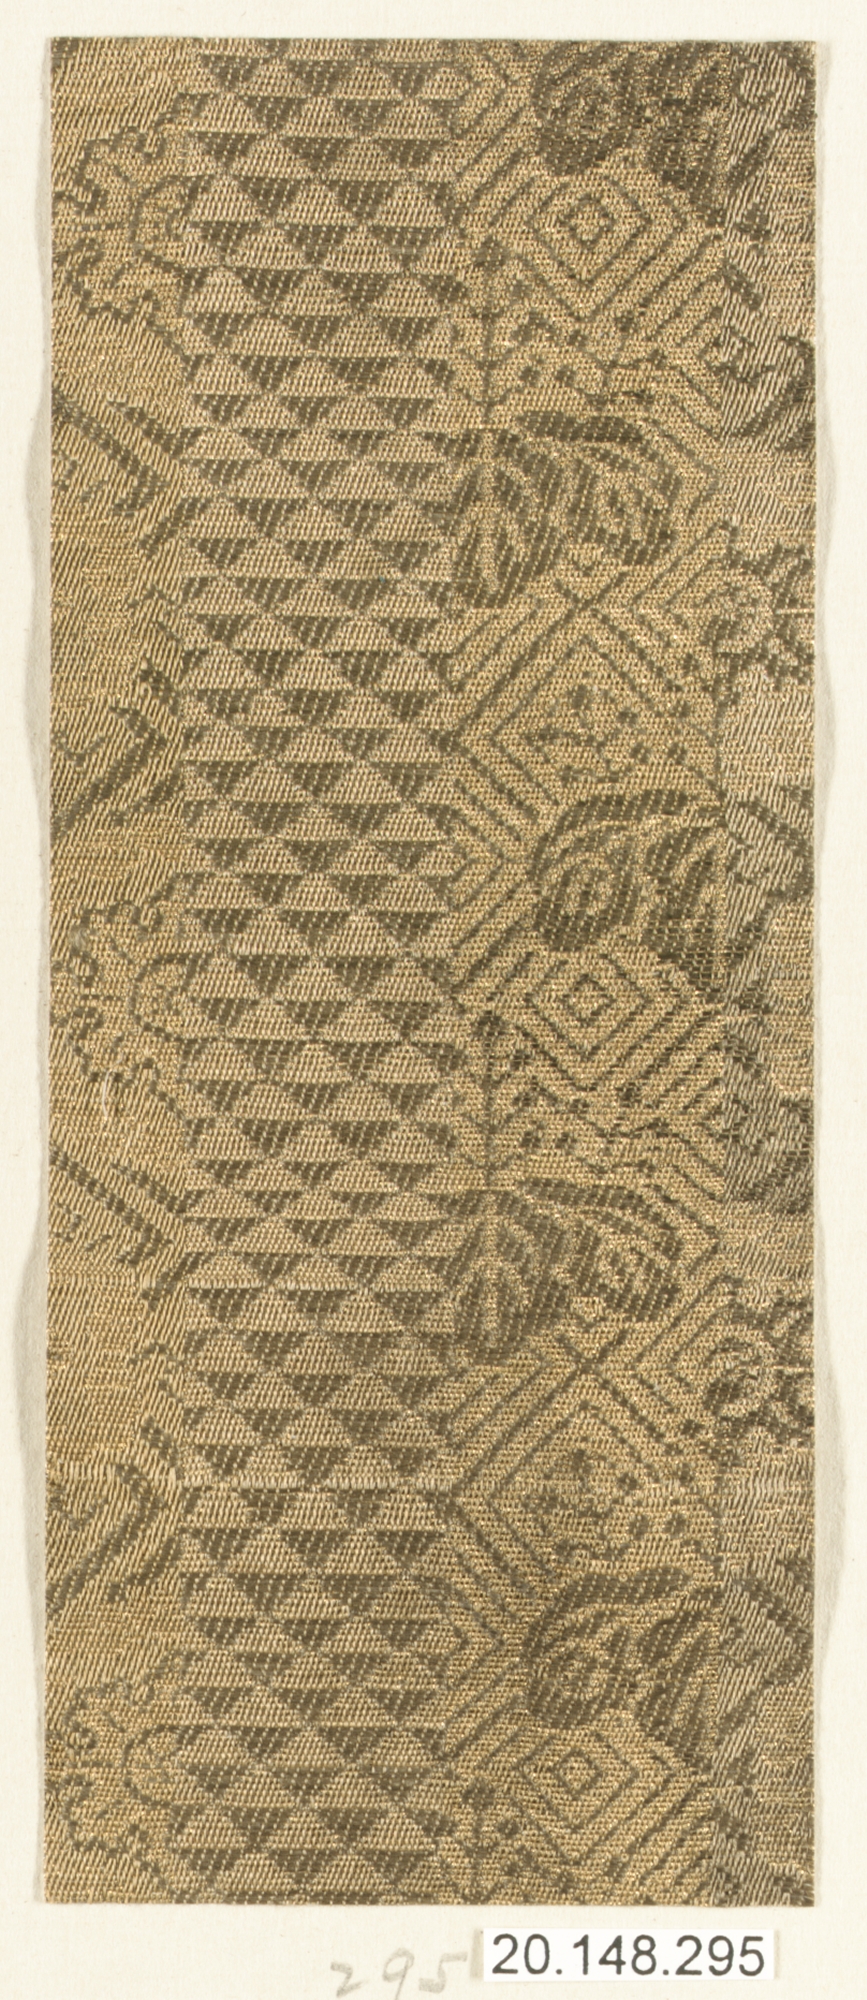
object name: piece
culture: japanese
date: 1701-1800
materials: silk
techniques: compound weave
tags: leaves